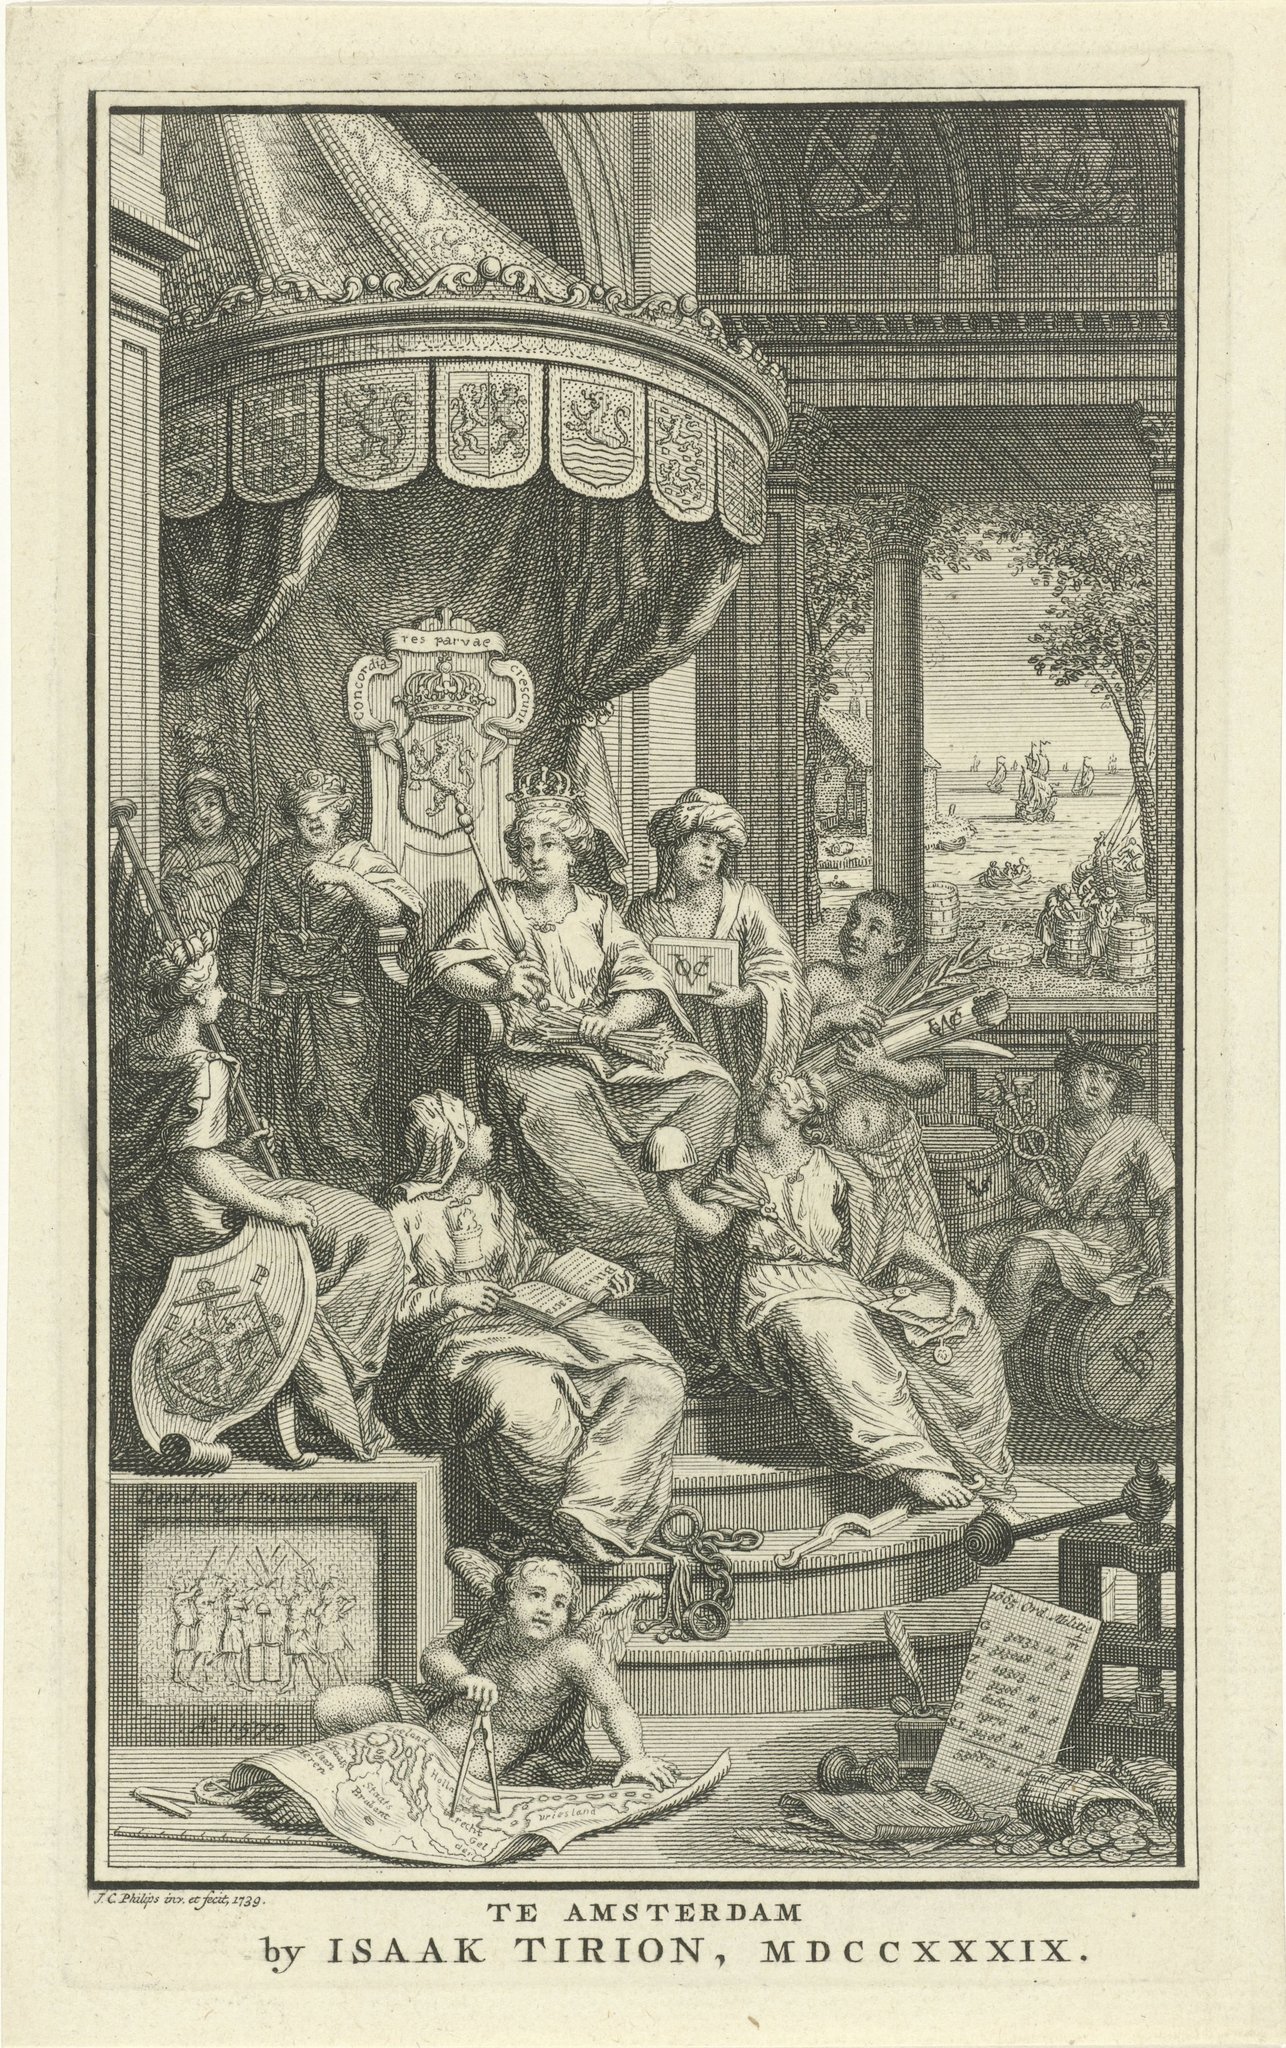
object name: print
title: Allegorie op de Republiek der Zeven Verenigde Nederlanden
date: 1739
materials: paper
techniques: engraving, etching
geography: amsterdam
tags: agreement, unity; 'concordia', 'concordia insuperabile', 'concordia militare', 'concordia di pace', 'unione civile' (ripa), justice, 'justitia'; 'giustitia divina' (ripa) ~ one of the four cardinal virtues, faith, 'fides'; 'fede', 'fede catholica', 'fede christiana', 'fede christiana catholica' (ripa) ~ one of the three theological virtues, (story of) mercury (hermes), freedom, liberty; 'libertà' (ripa)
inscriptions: collector's mark: Lugt 2228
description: Vertrek met de gepersonifieerde Eendracht op een troon die is versierd met het wapenschild van de Republiek der Zeven Verenigde Nederlanden. Ze wordt vergezeld door figuren die symbool staan voor de voorspoed die zij de Republiek brengt. Op de voorgrond een putto met een landkaart van de Republiek. Op de achtergrond een gezicht op een haven.